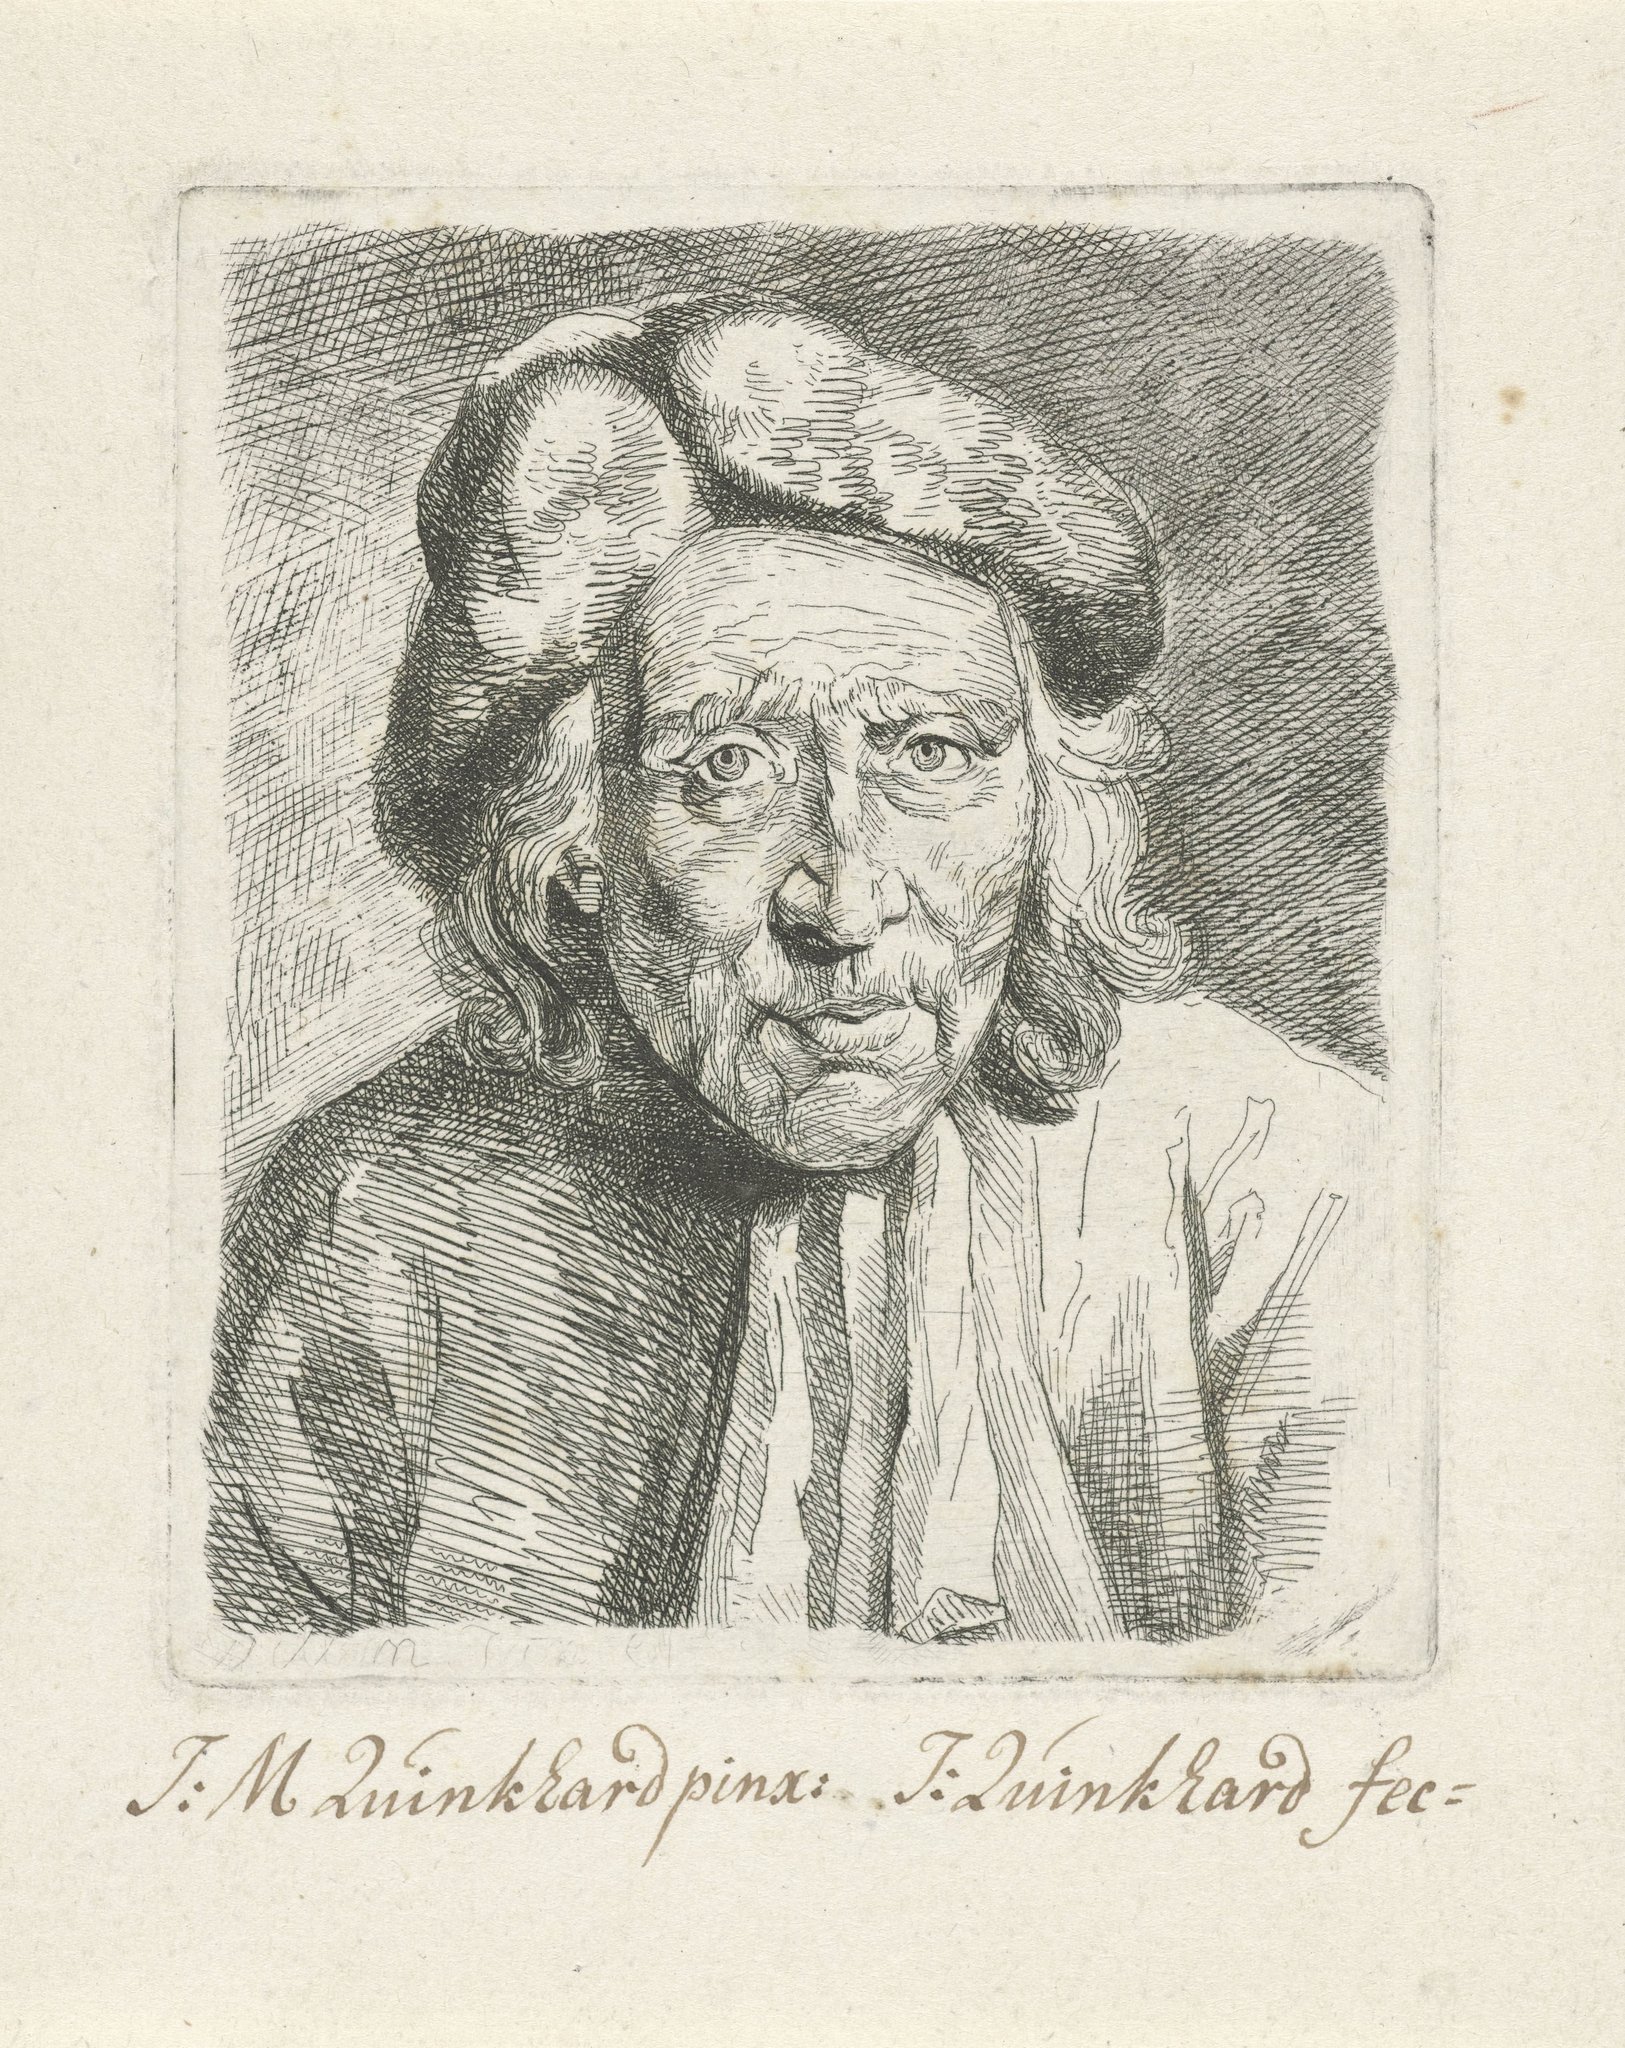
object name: print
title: Portret van Willem Jansz. Koster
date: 1744-1795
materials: paper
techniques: etching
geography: amsterdam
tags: head-gear: cap (+ men's clothes)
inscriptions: inscription: ‘J:M Quinkhard pinx J: Quinkhard fec:’, collector's mark: Lugt 240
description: Portret van Willem Jansz. Koster. Hij stierf te Muiden en werd 112 jaar.